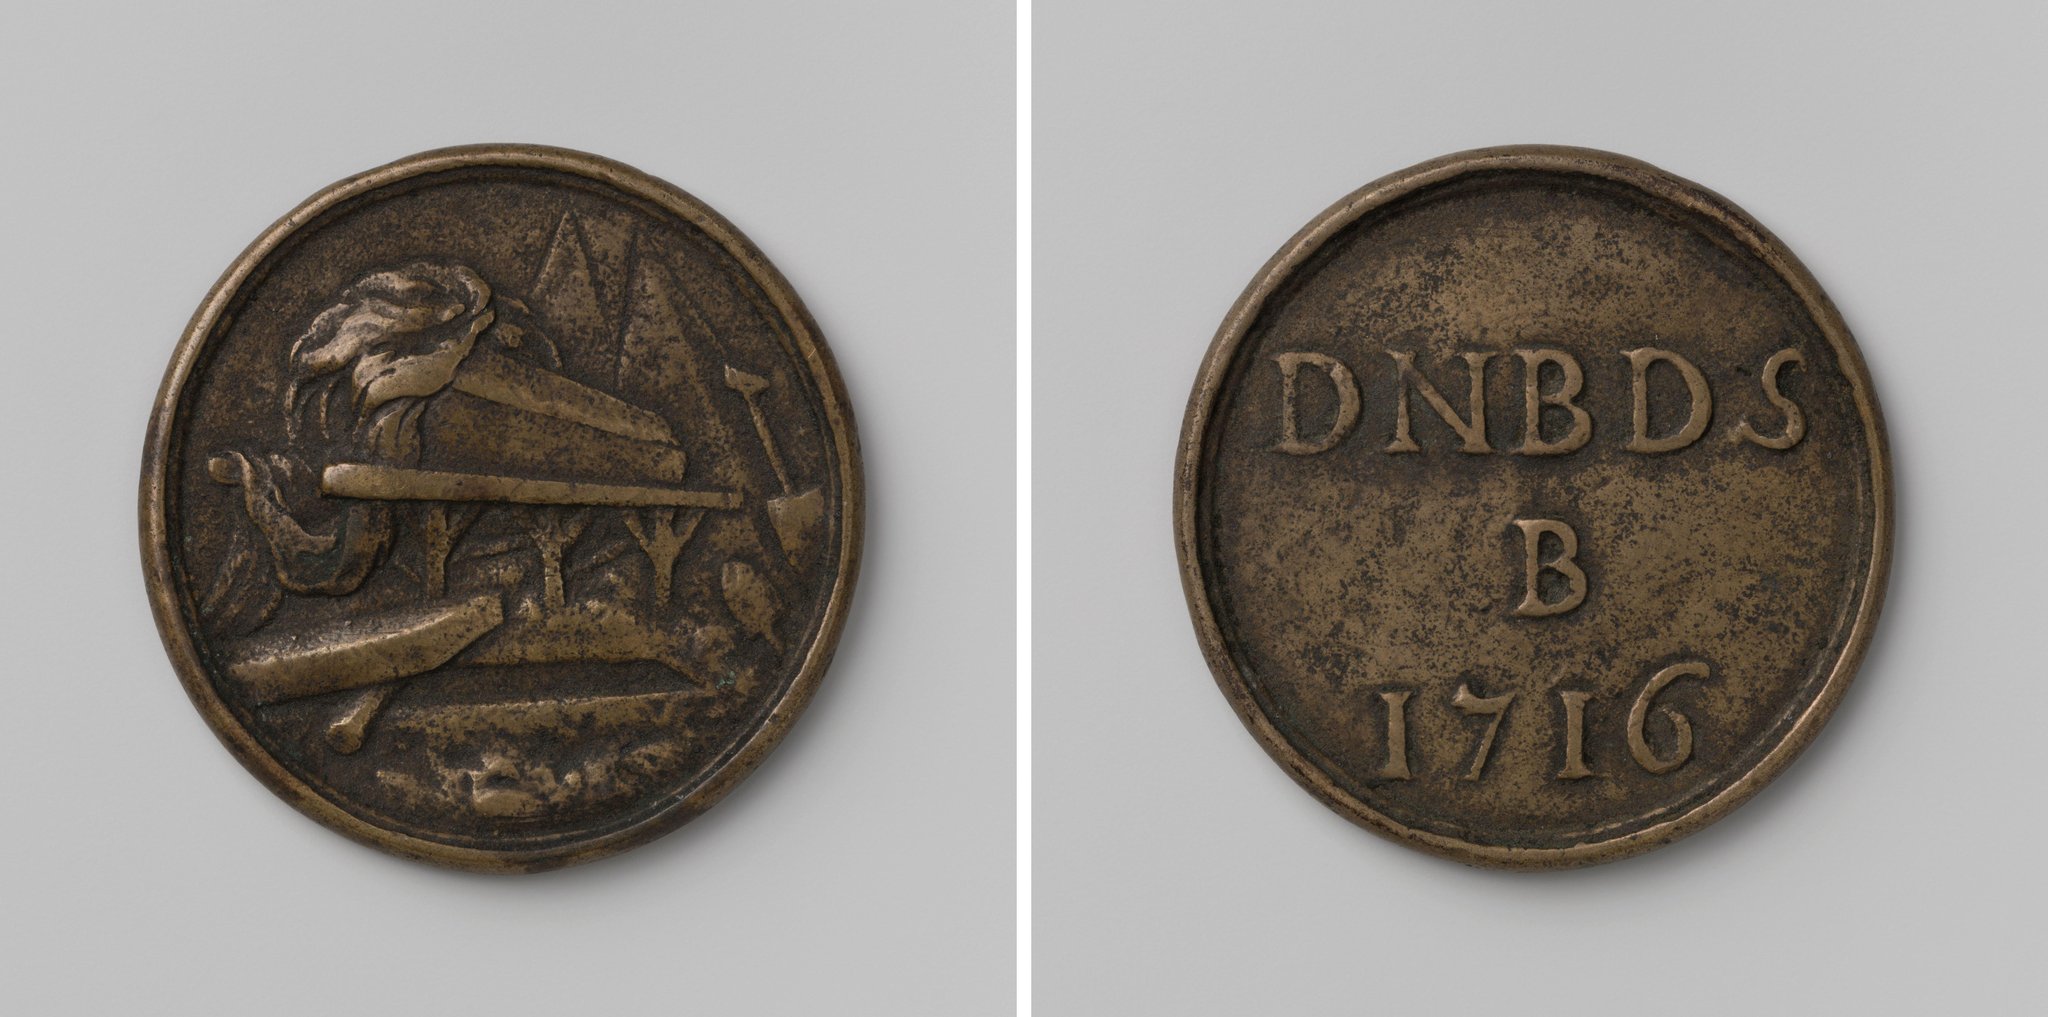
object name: buurtpenning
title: Buurt van de Noordelijke Brouwersdwarsstraat te 's-Gravenhage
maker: Anonymous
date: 1716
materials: brass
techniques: casting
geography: the hague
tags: noordelijke brouwersdwarsstraat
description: Messing penning. Voorzijde: doodskist op baar naast open graf; op achtergrond twee pyramides, waar schoppen bij staan. Keerzijde: opschrift boven jaartal